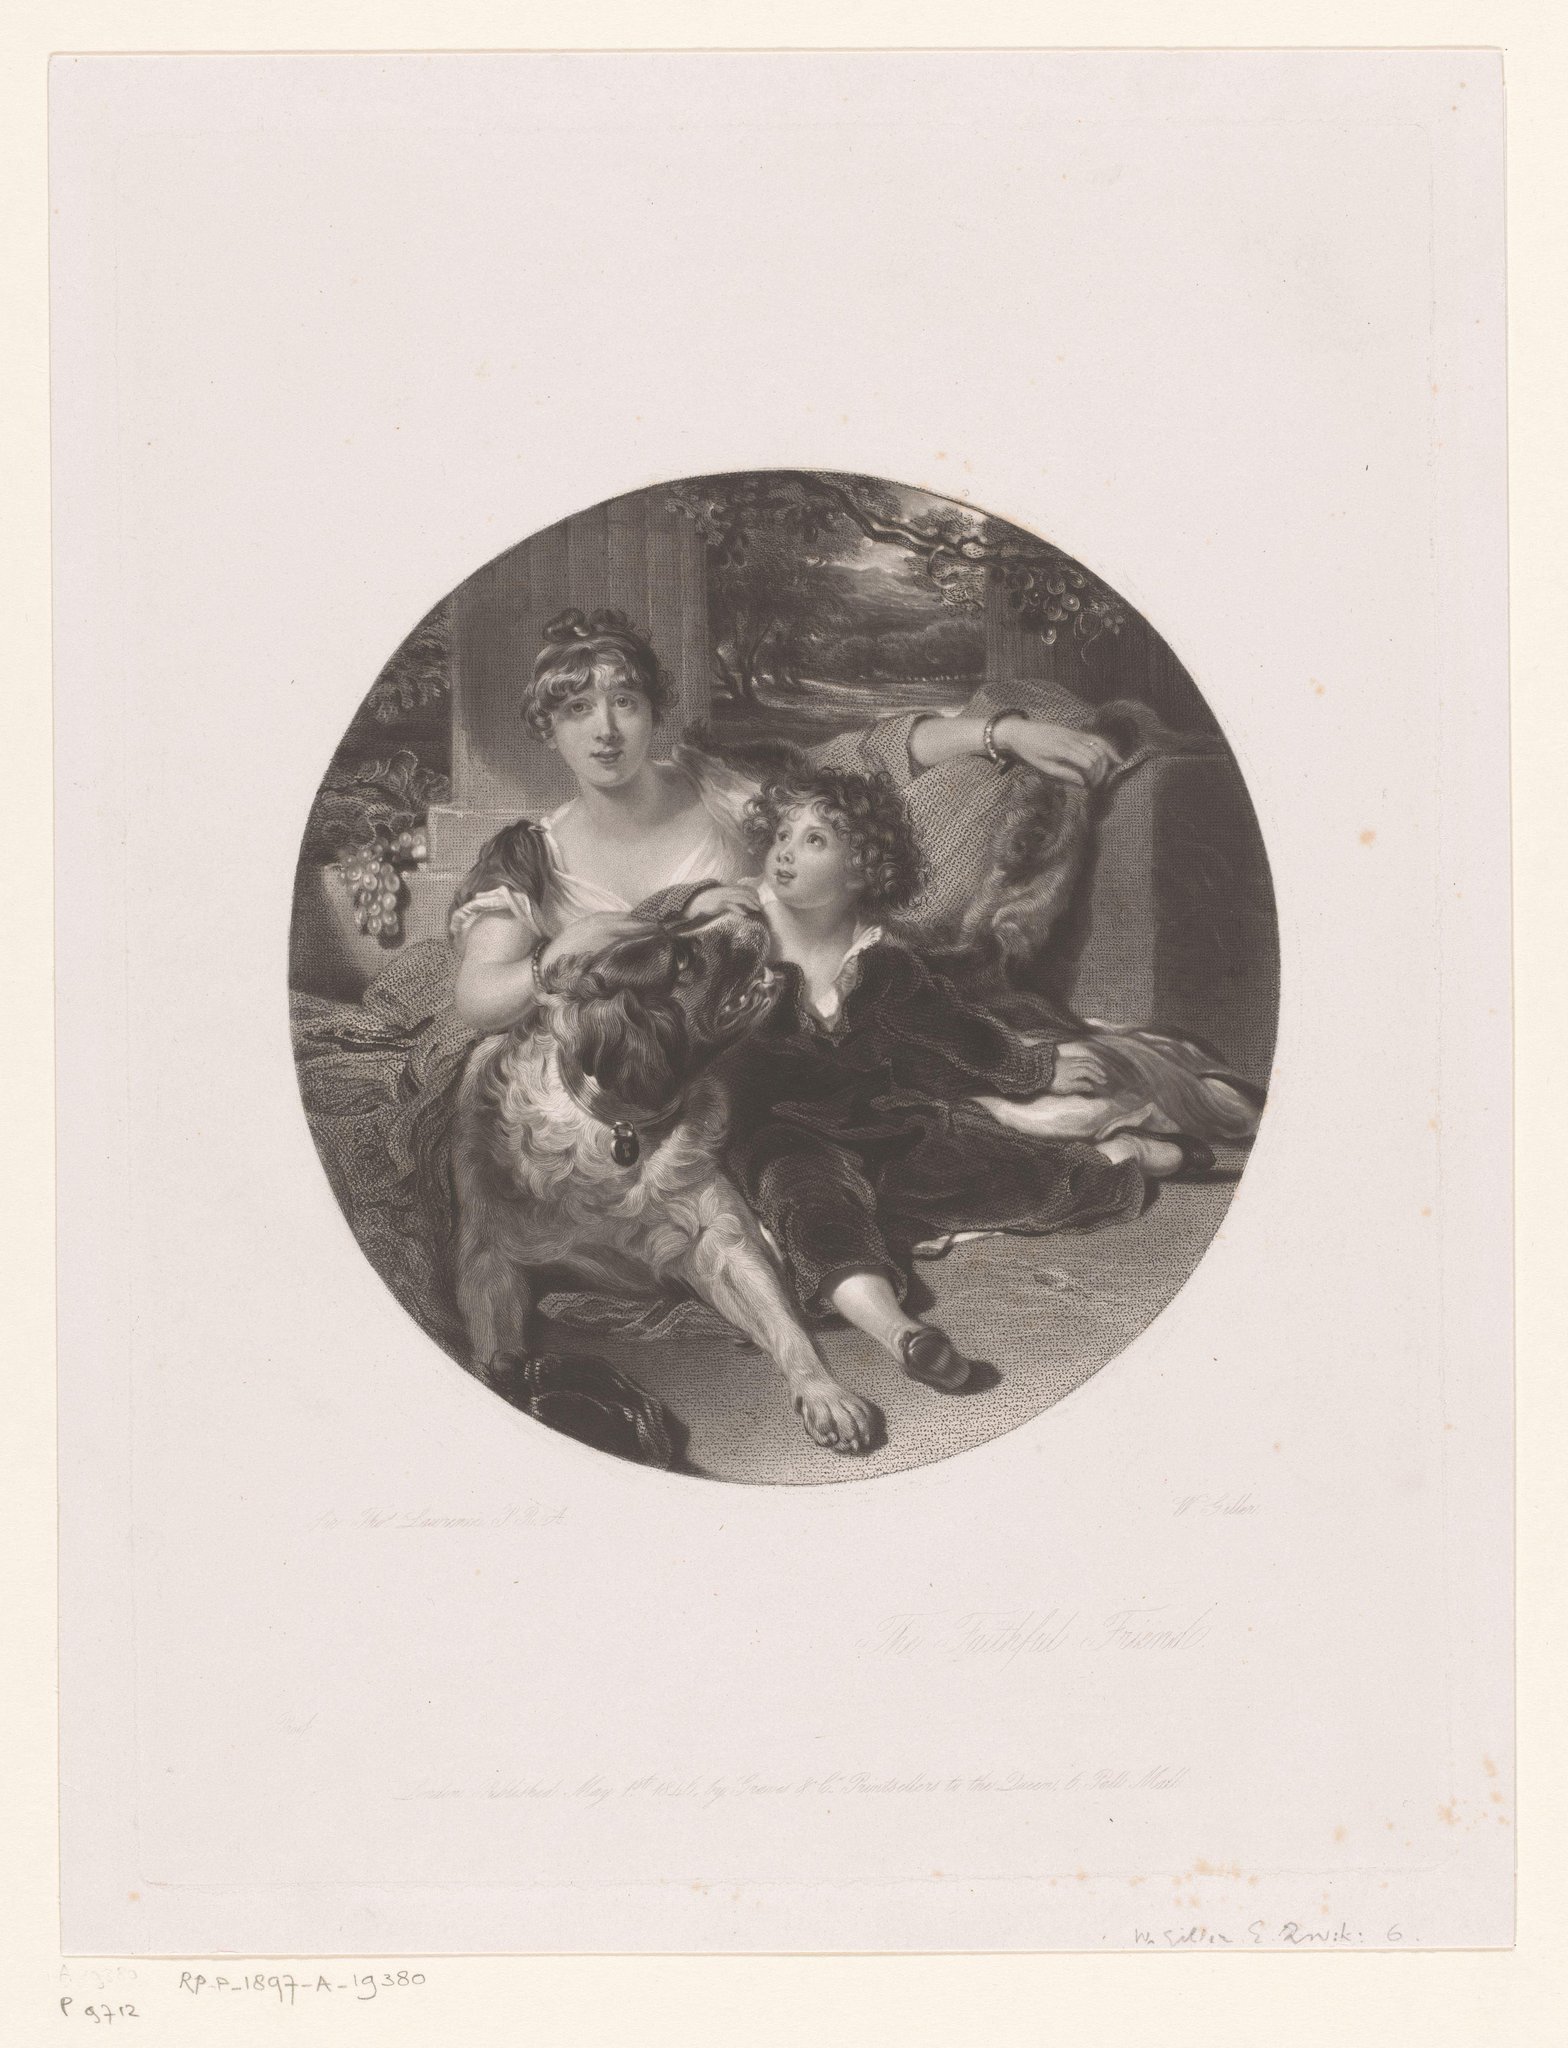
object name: print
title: The Faithful Friend, Portrait of Mrs Maguire, with her Son John James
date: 1846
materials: paper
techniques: etching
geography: london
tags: mother with son(s) (mother-love), dog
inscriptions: collector's mark: Lugt 2228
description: This little print reproduces a painting with a diameter of 160 centimetres. It was exhibited in 1806 under the neutral title A Fancy Picture. However, it was soon recognized as a portrait of the mistress of the marquis of Abercorn, with their little boy. The title of the print The Faithful Friend refers to their huge newfoundland in the foreground.